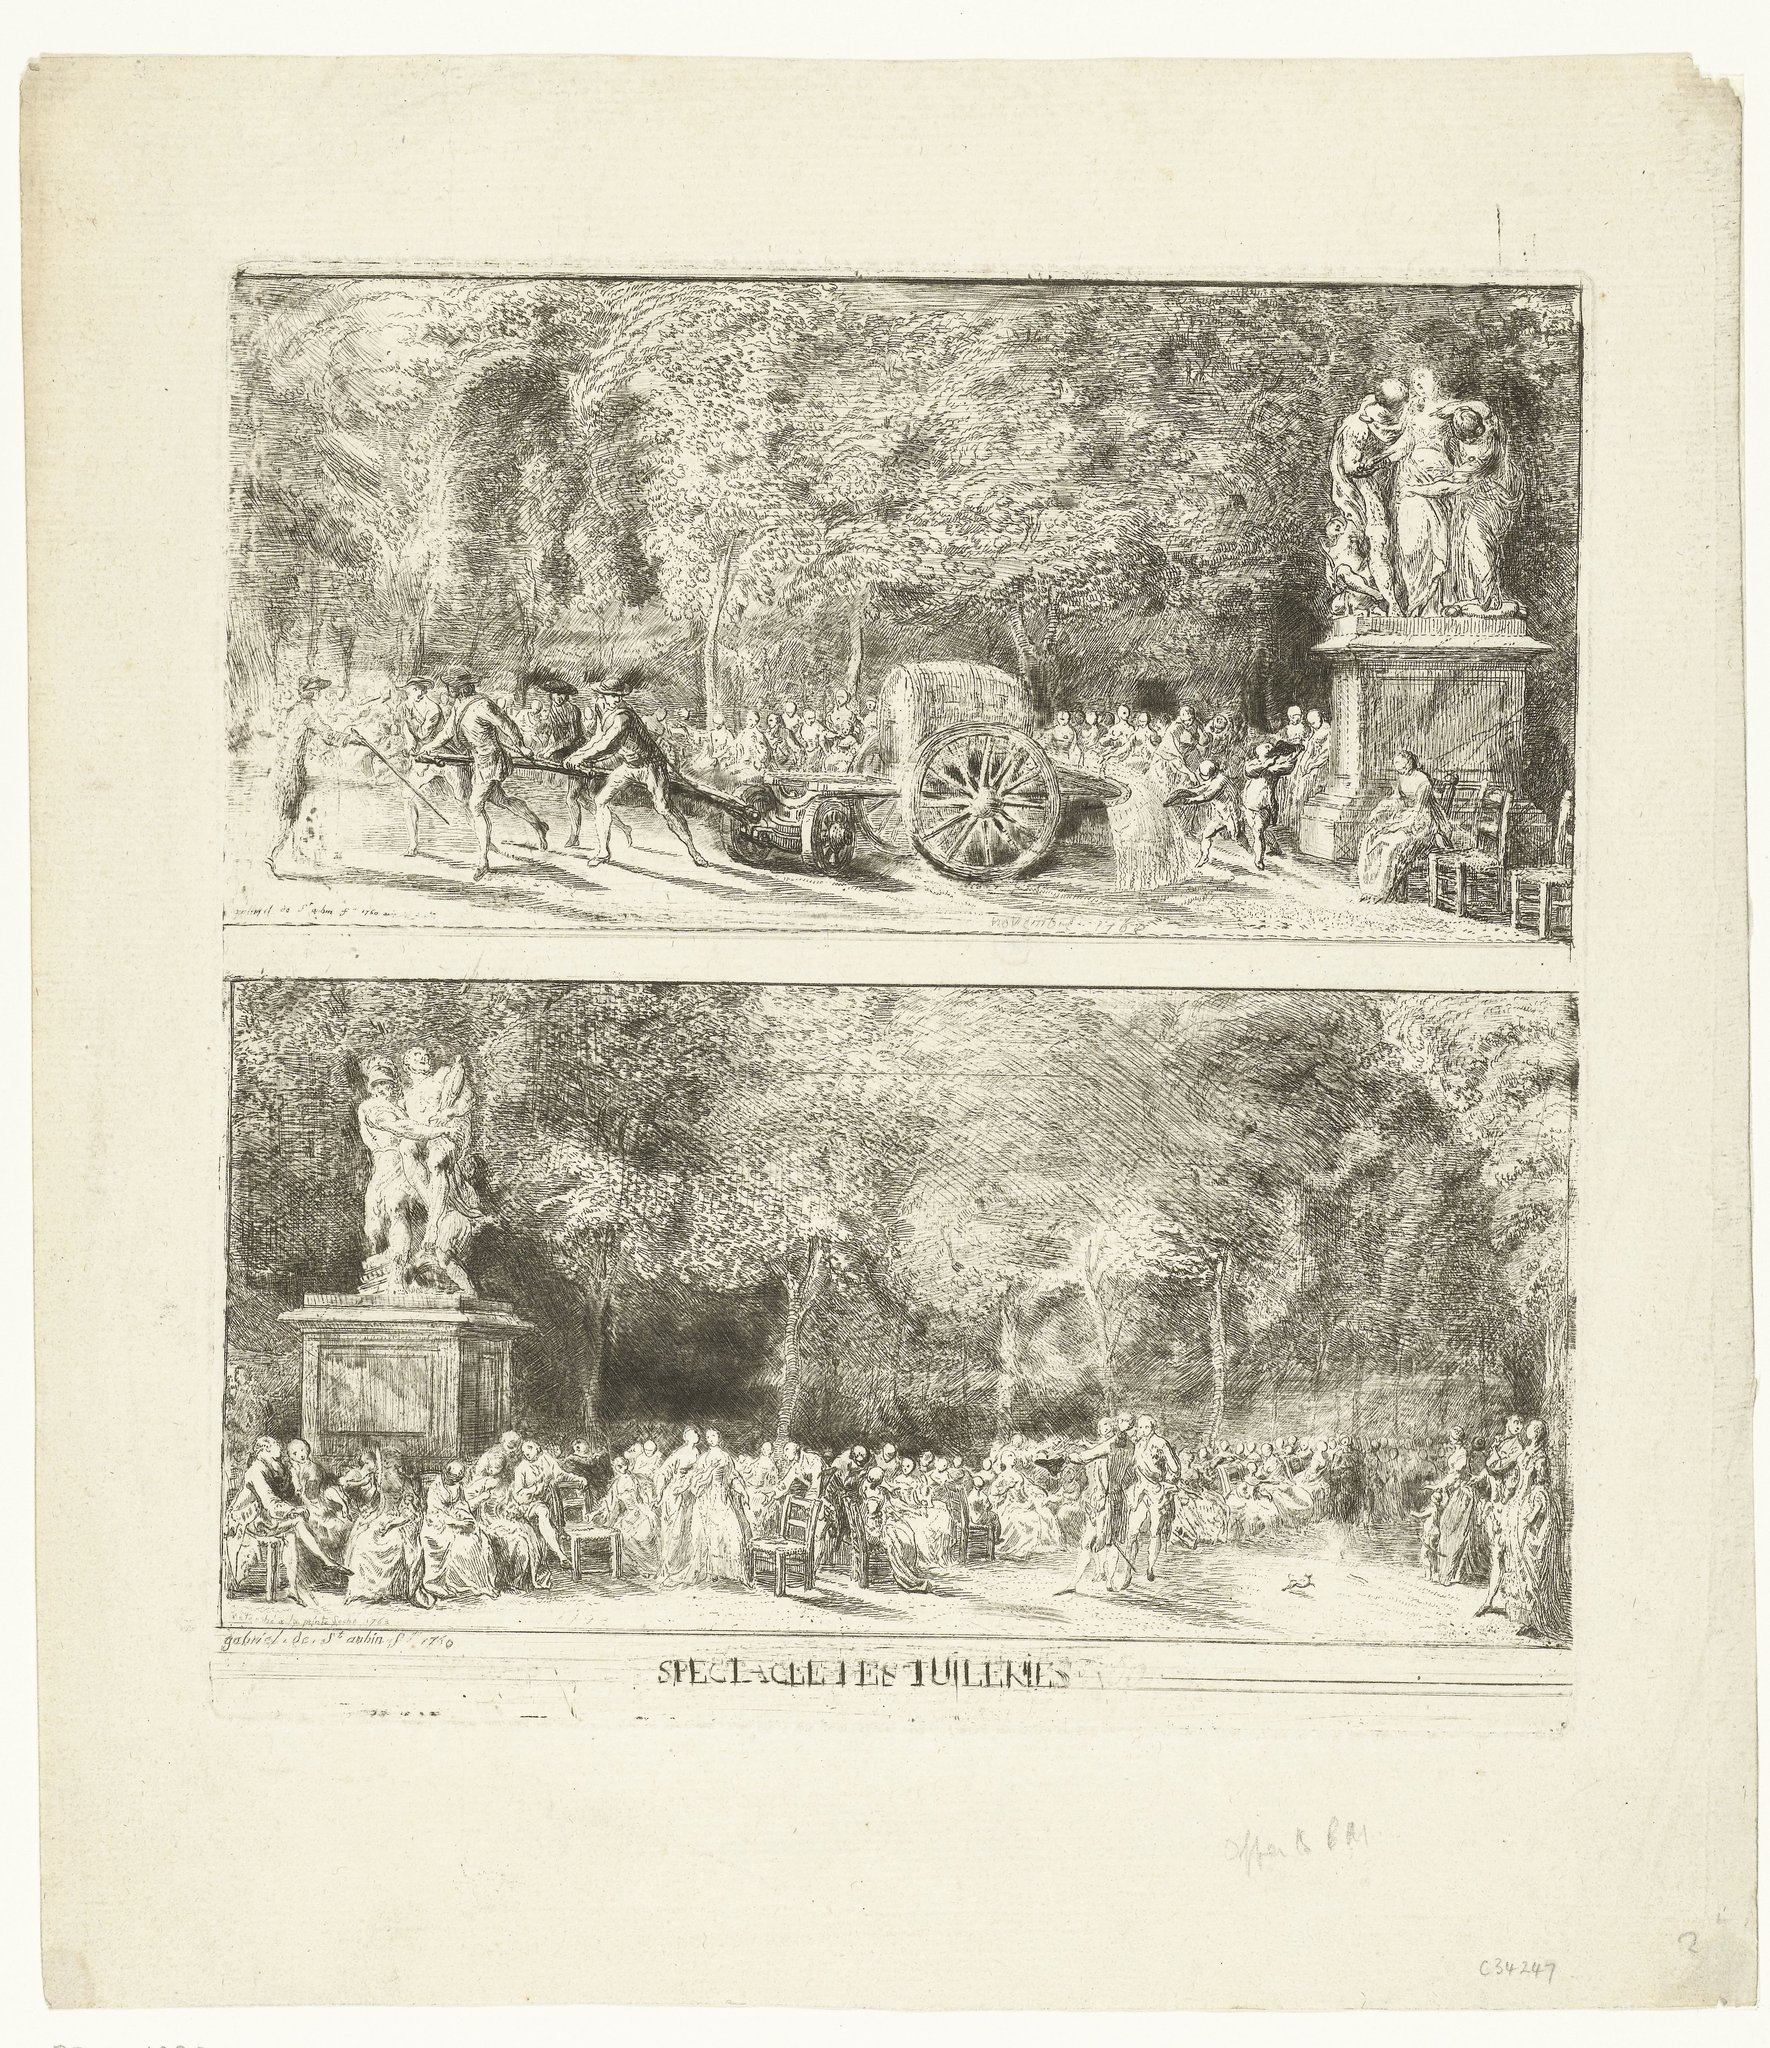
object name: print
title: Spectacle des Tuileries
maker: gabriel jacques de saint-aubin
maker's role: draughtsman, print maker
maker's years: 1724-1780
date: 1760-1763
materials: paper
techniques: etching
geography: paris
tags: chair, public gardens, park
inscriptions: collector's mark: Lugt 2228, collector's mark: Lugt 2760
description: Twee voorstellingen op één plaat. Boven: een kar getrokken door vier mannen, met daarop een ton waaruit water wordt gesproeid tegen het opwaaiende stof. Onder: Een grote groep mannen en vrouwen zitten op stoelen in het park.